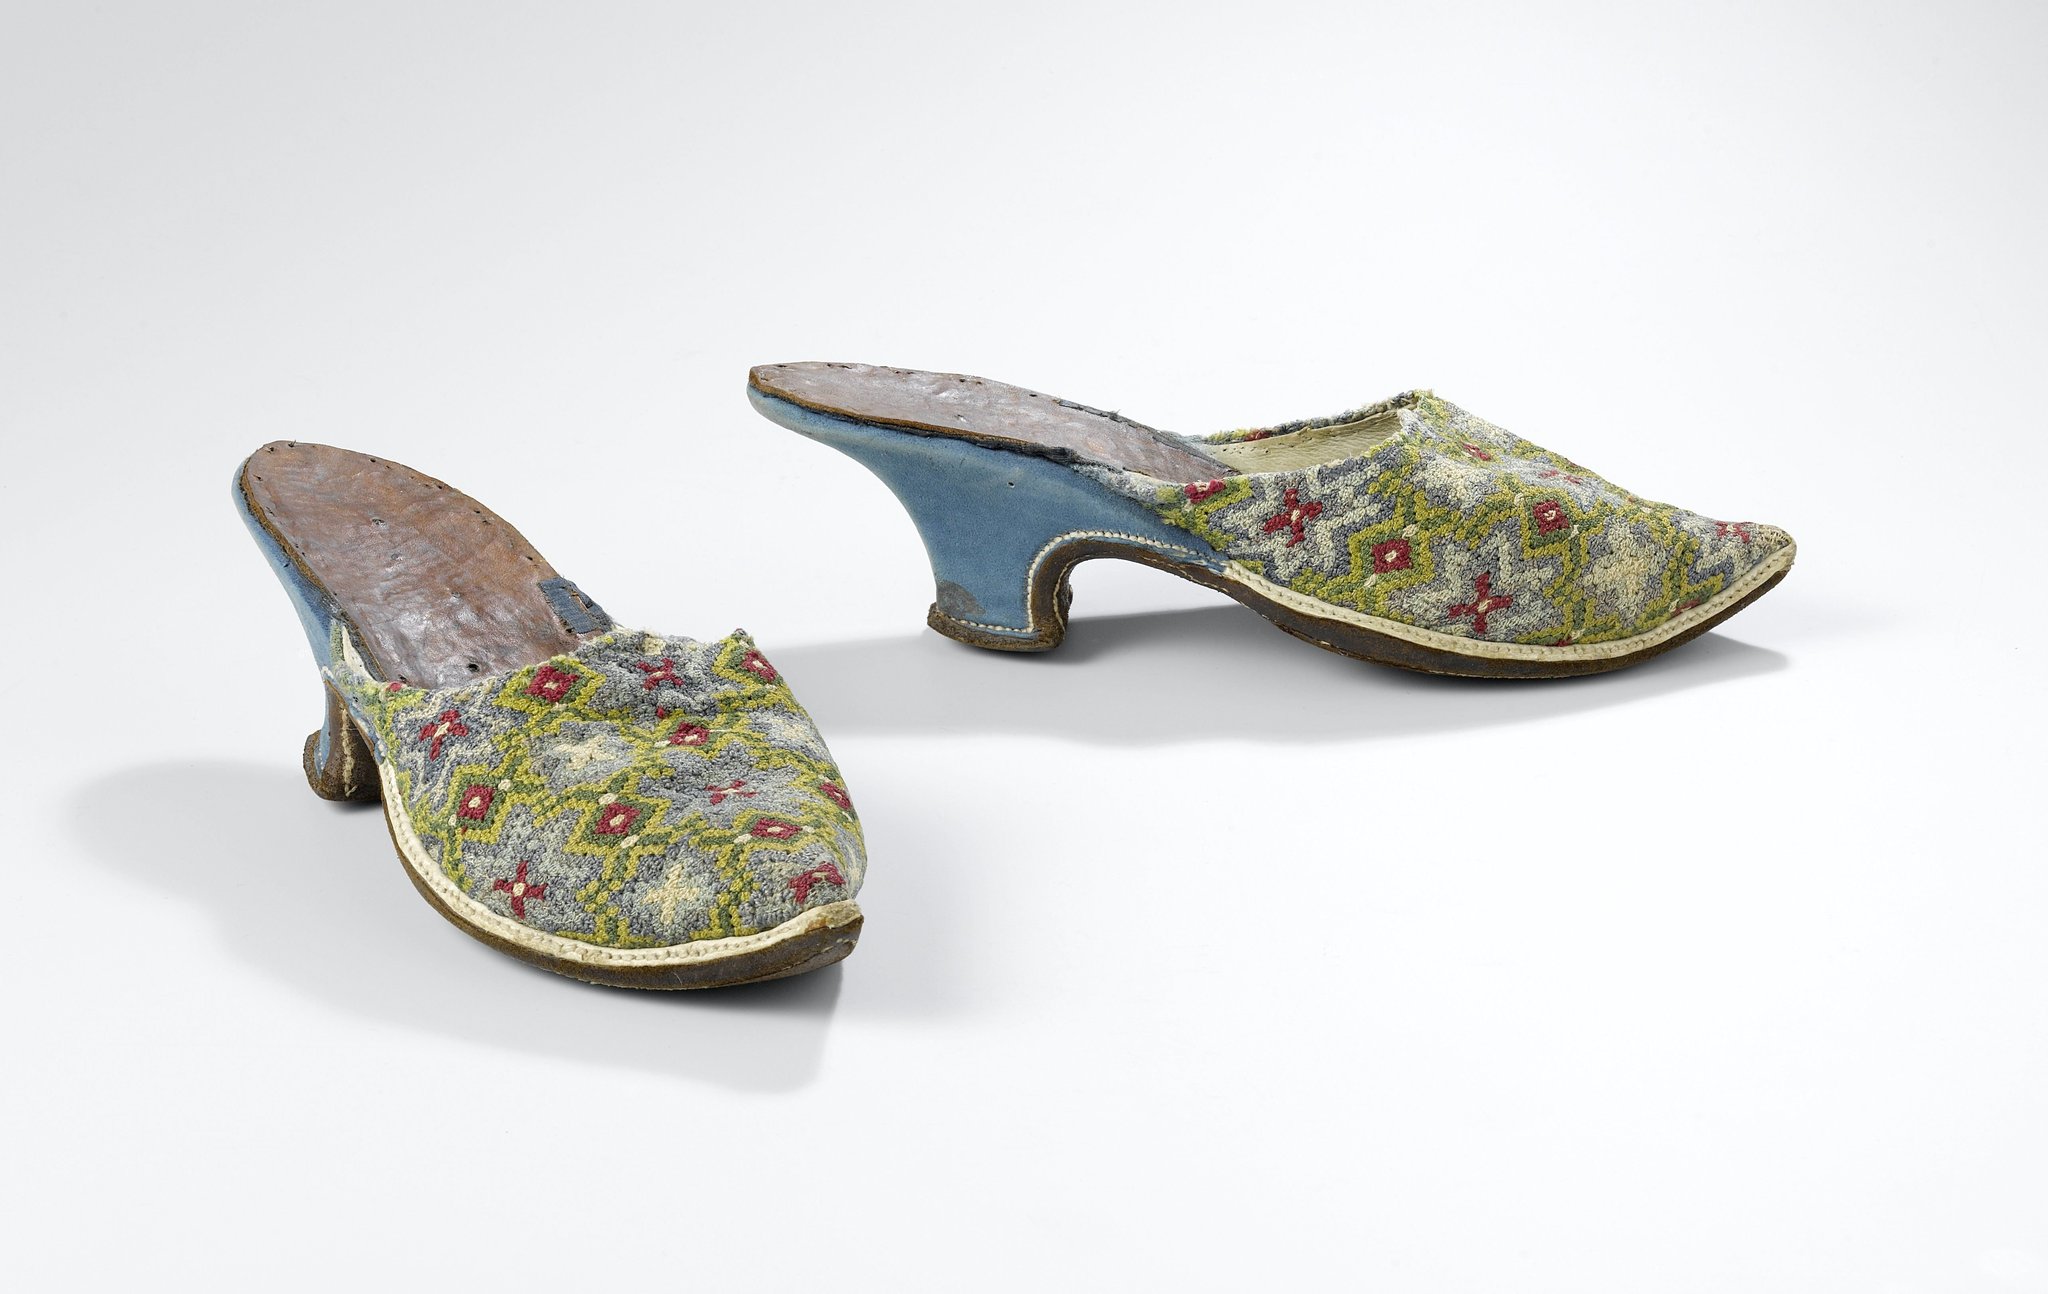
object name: mule shoe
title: Muiltje met geborduurd voorblad zijde op stramien, met patroon van blauwe sterbloemen op geel fond met groen netwerk met rode ruiten en witte punten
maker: Anonymous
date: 1660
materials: leather, linen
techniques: embroidered, tanning, weave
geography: netherlands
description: Muiltje met voorblad van borduurwerk van zijde op stramien, met patroon van blauwe sterbloemen op geel fond met groen netwerk met rode ruiten en witte punten. Model: Brede voorvoet, spitse punt. De hak staat halverwege het geleng en is bekleed met blauw geruwd leer. Langs de rand van de hak zijn witte stiksels. De voorkant van de hak loopt in een afgeronde hoek vanaf het begin van het geleng recht naar beneden. De achterkant van de hak loopt in een afgeronde hoek recht naar beneden. Het verloop van de achterkant van de hak naar de zijkanten van de hak gaat in een hoek. Voorblad gevoerd met ivoorwit glacéleer. Tussen het voorblad en de zool is een band ivoorwit glacéleer gestikt. De binnenzool is van donkerbruin leer. De zool is van donkerbruin leer. Het gedeelte van de zool die de grond raakt is van geruwd leer.